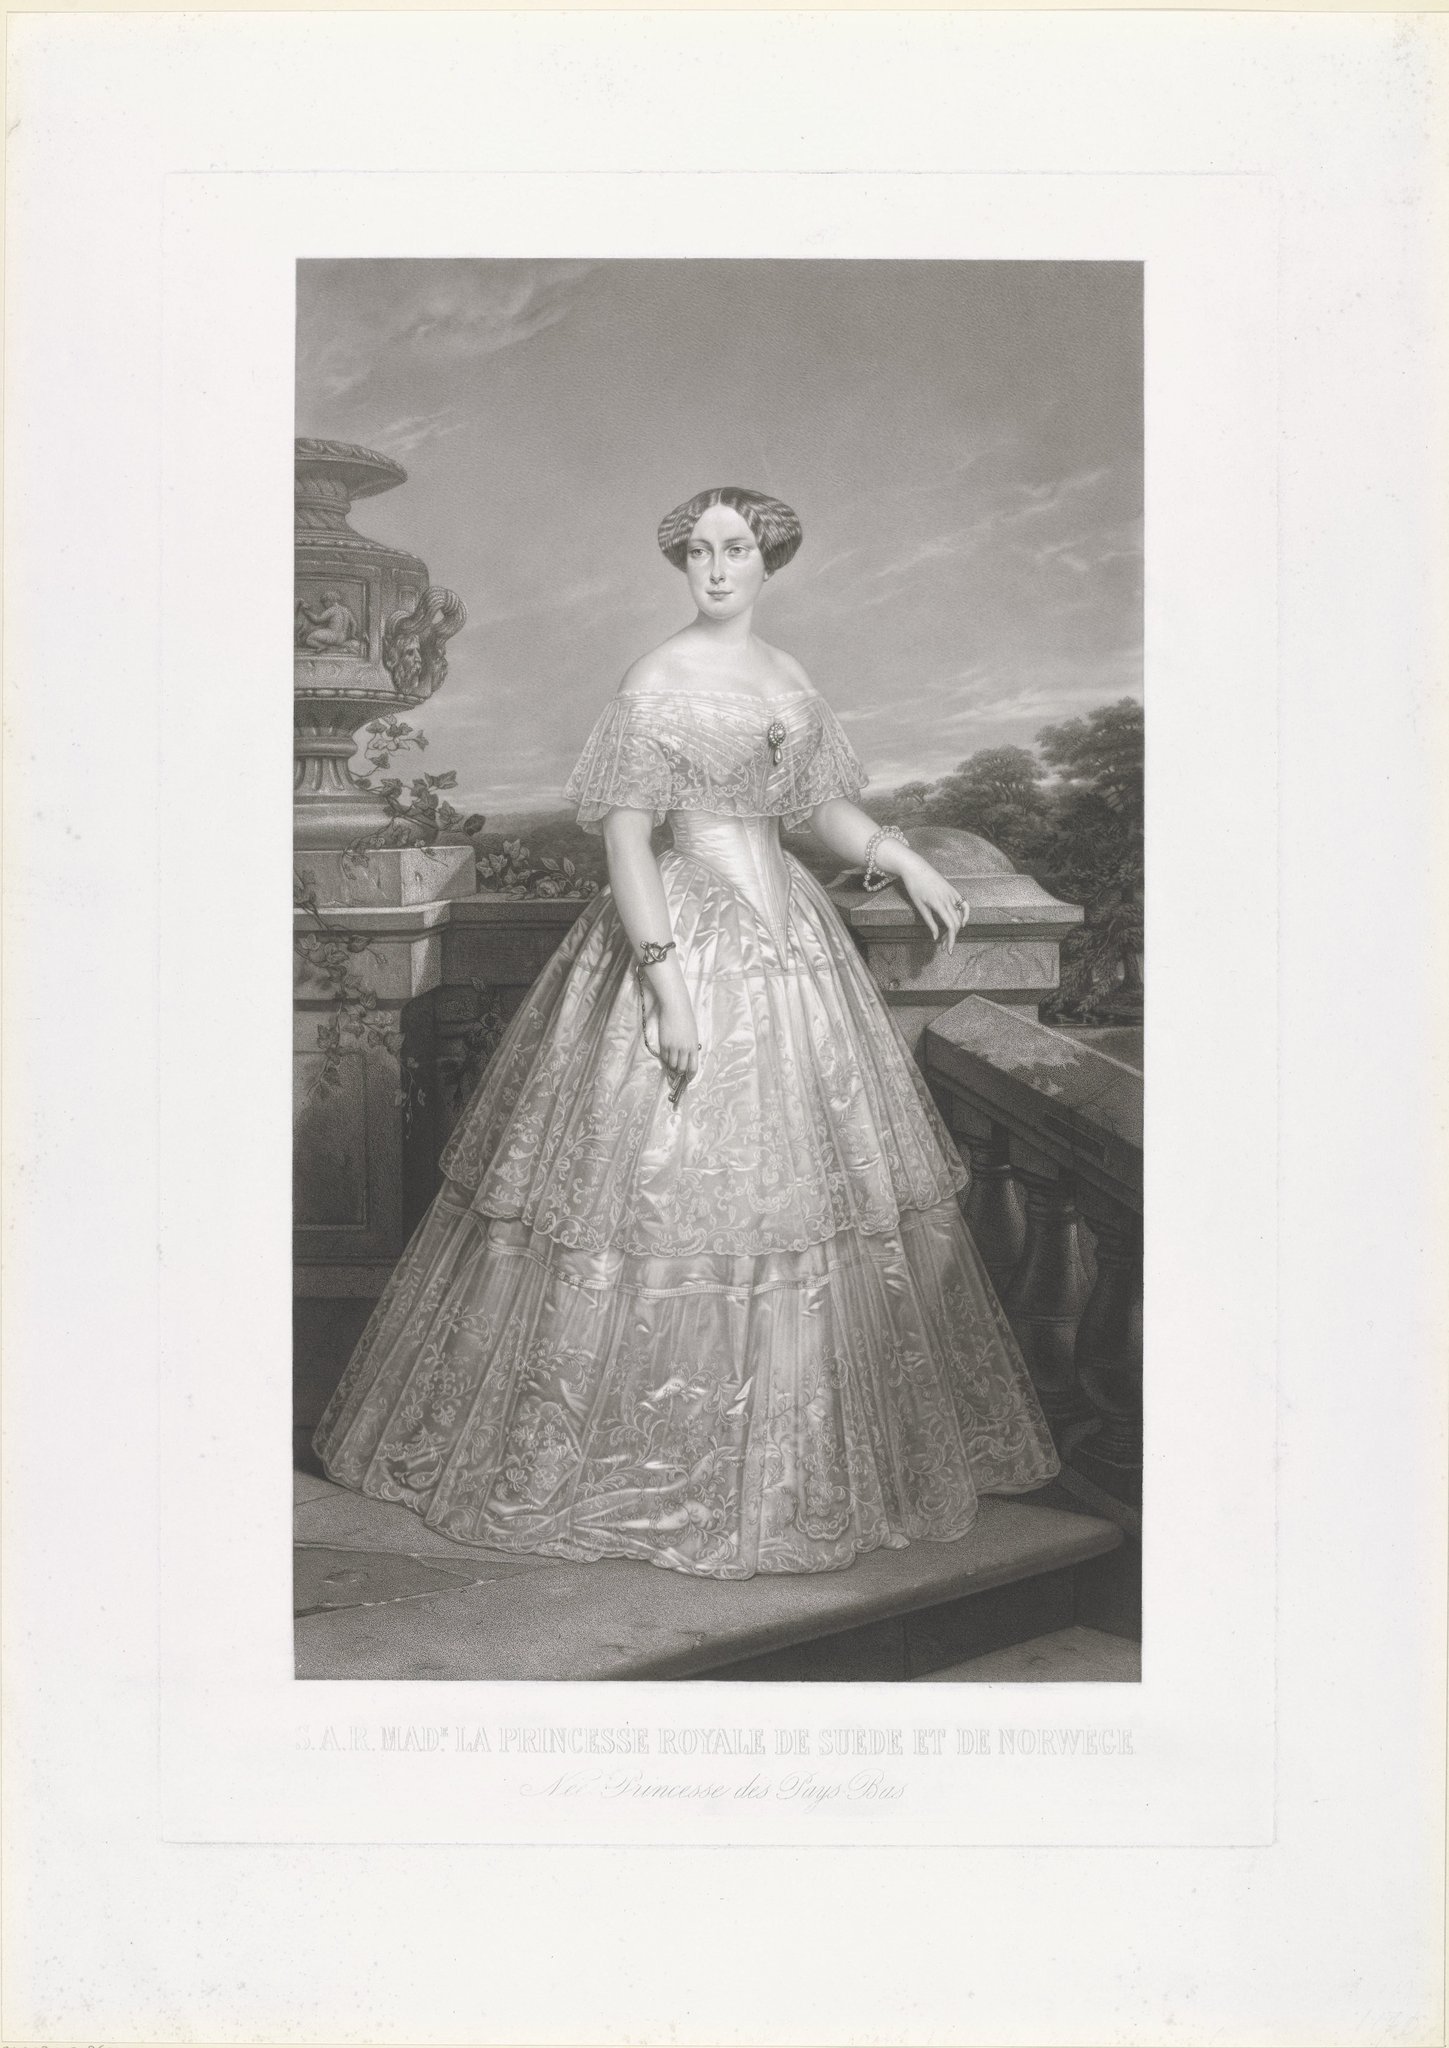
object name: print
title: Portret van Louise, prinses der Nederlanden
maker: jean baptiste alfred cornilliet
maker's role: print maker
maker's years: 1807-1895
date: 1850-1859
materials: paper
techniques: etching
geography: netherlands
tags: the hague, historical persons - bb - woman, princess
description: Portret van Louise. Ze staat op een bordes. In de ondermarge haar titels.